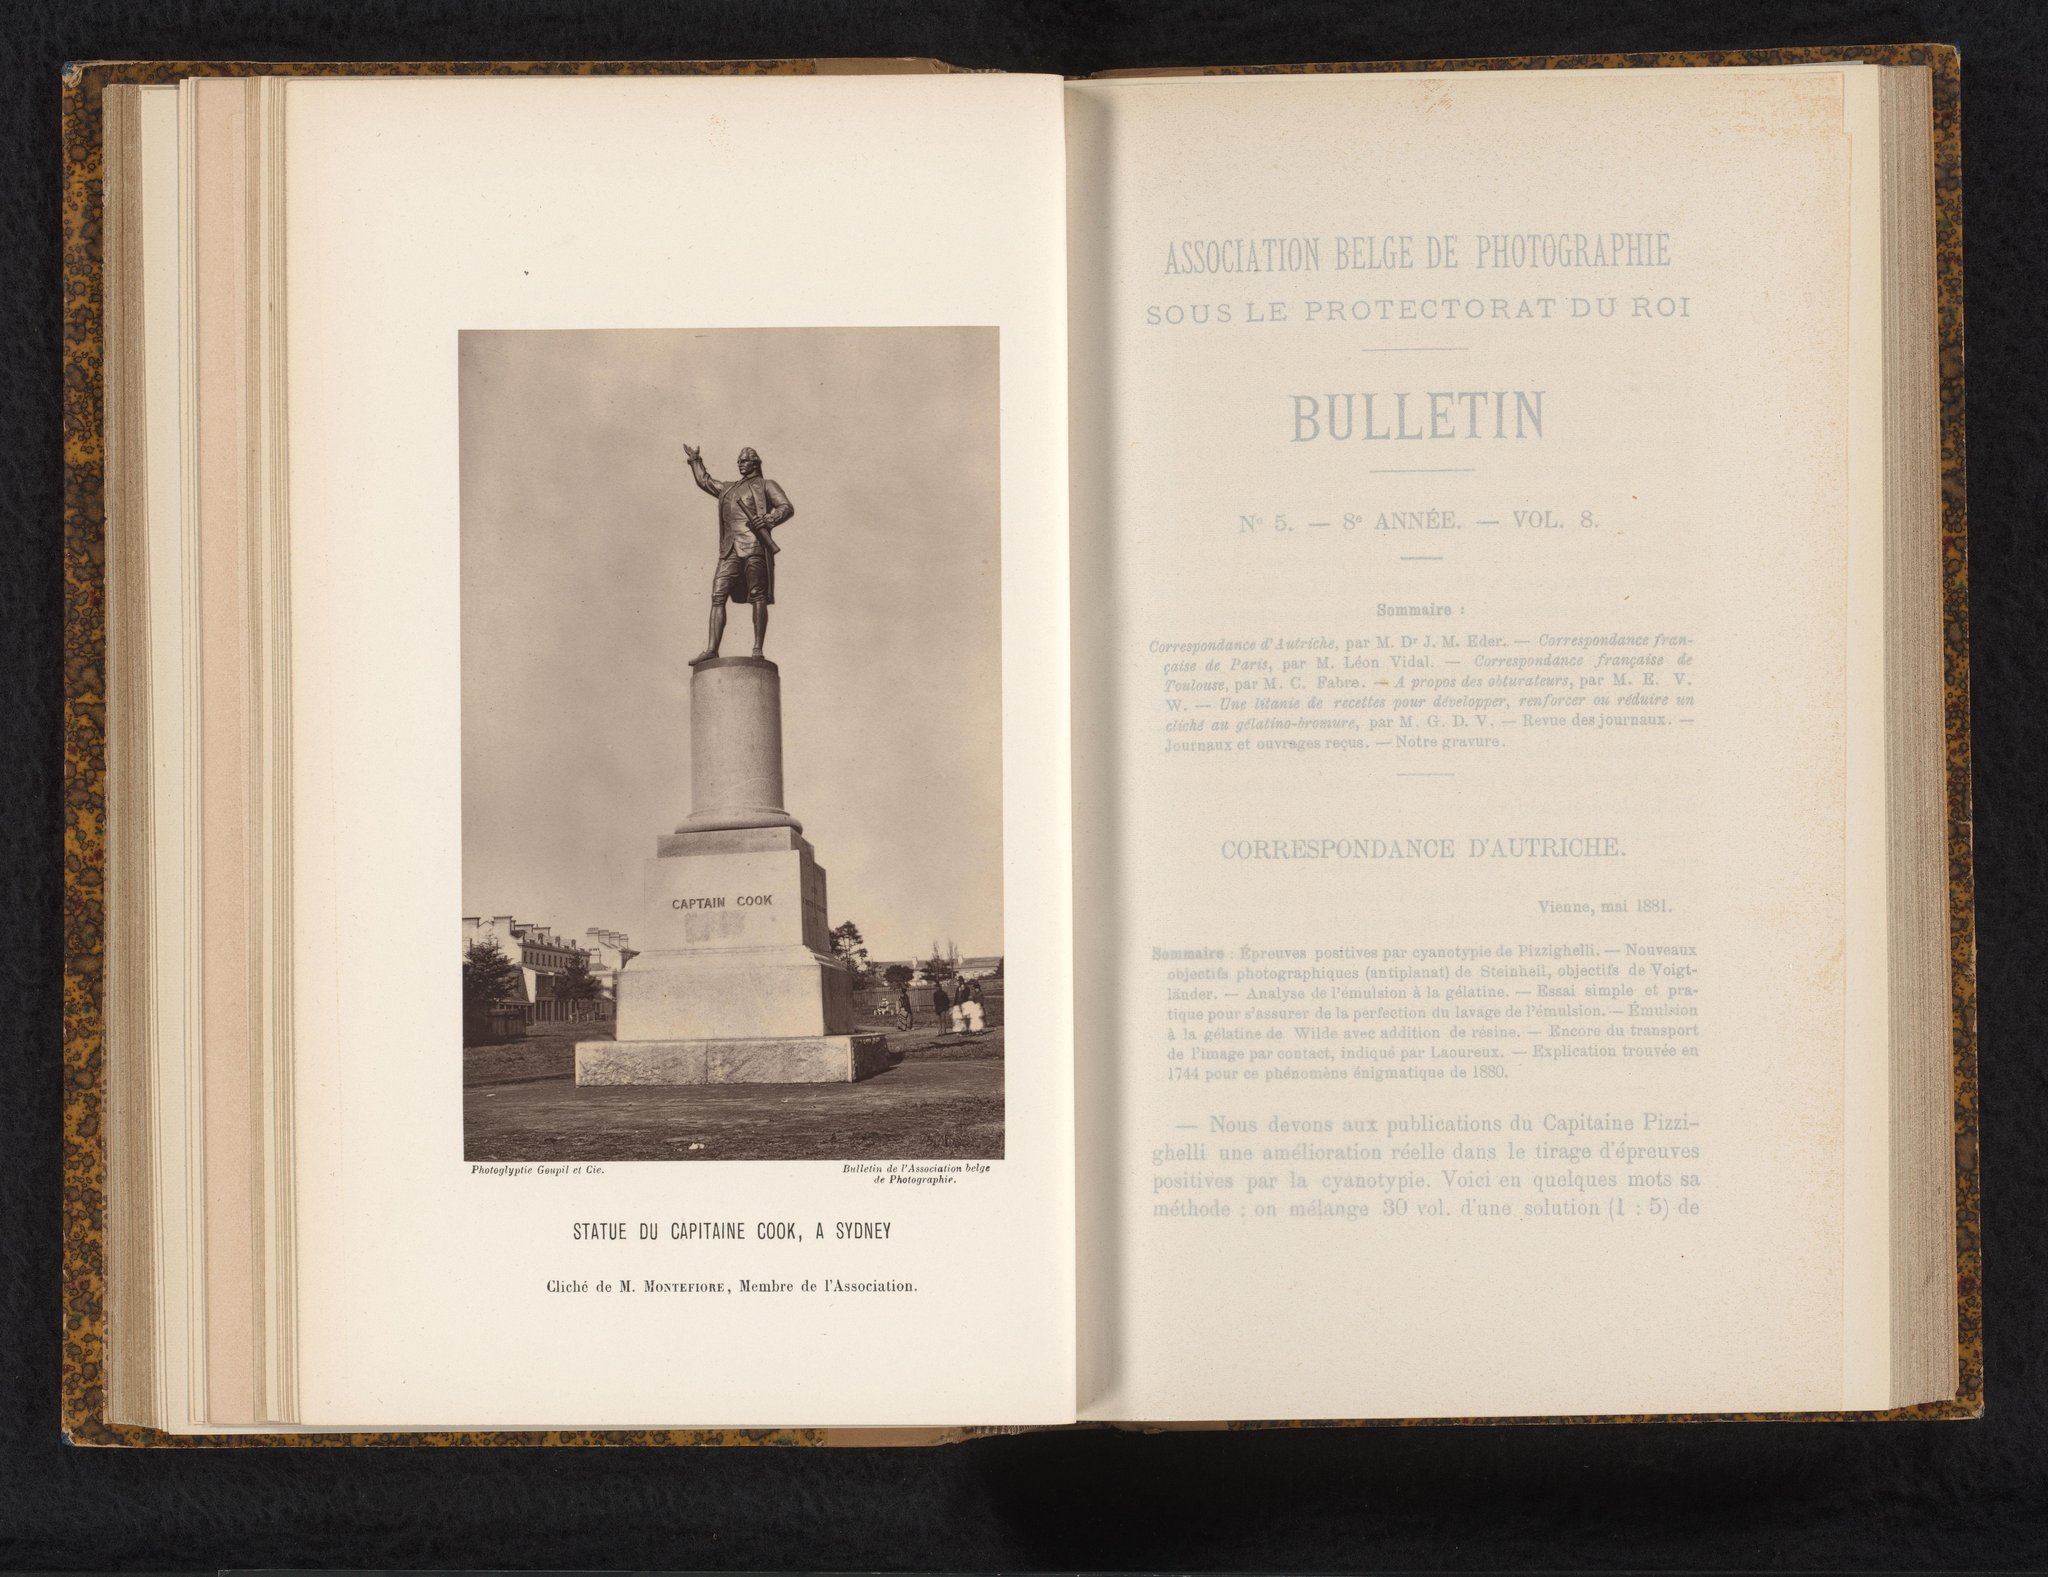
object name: page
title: Standbeeld van James Cook, Sydney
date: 1876-1881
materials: paper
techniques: woodburytype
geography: paris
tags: james cook, monument, statue